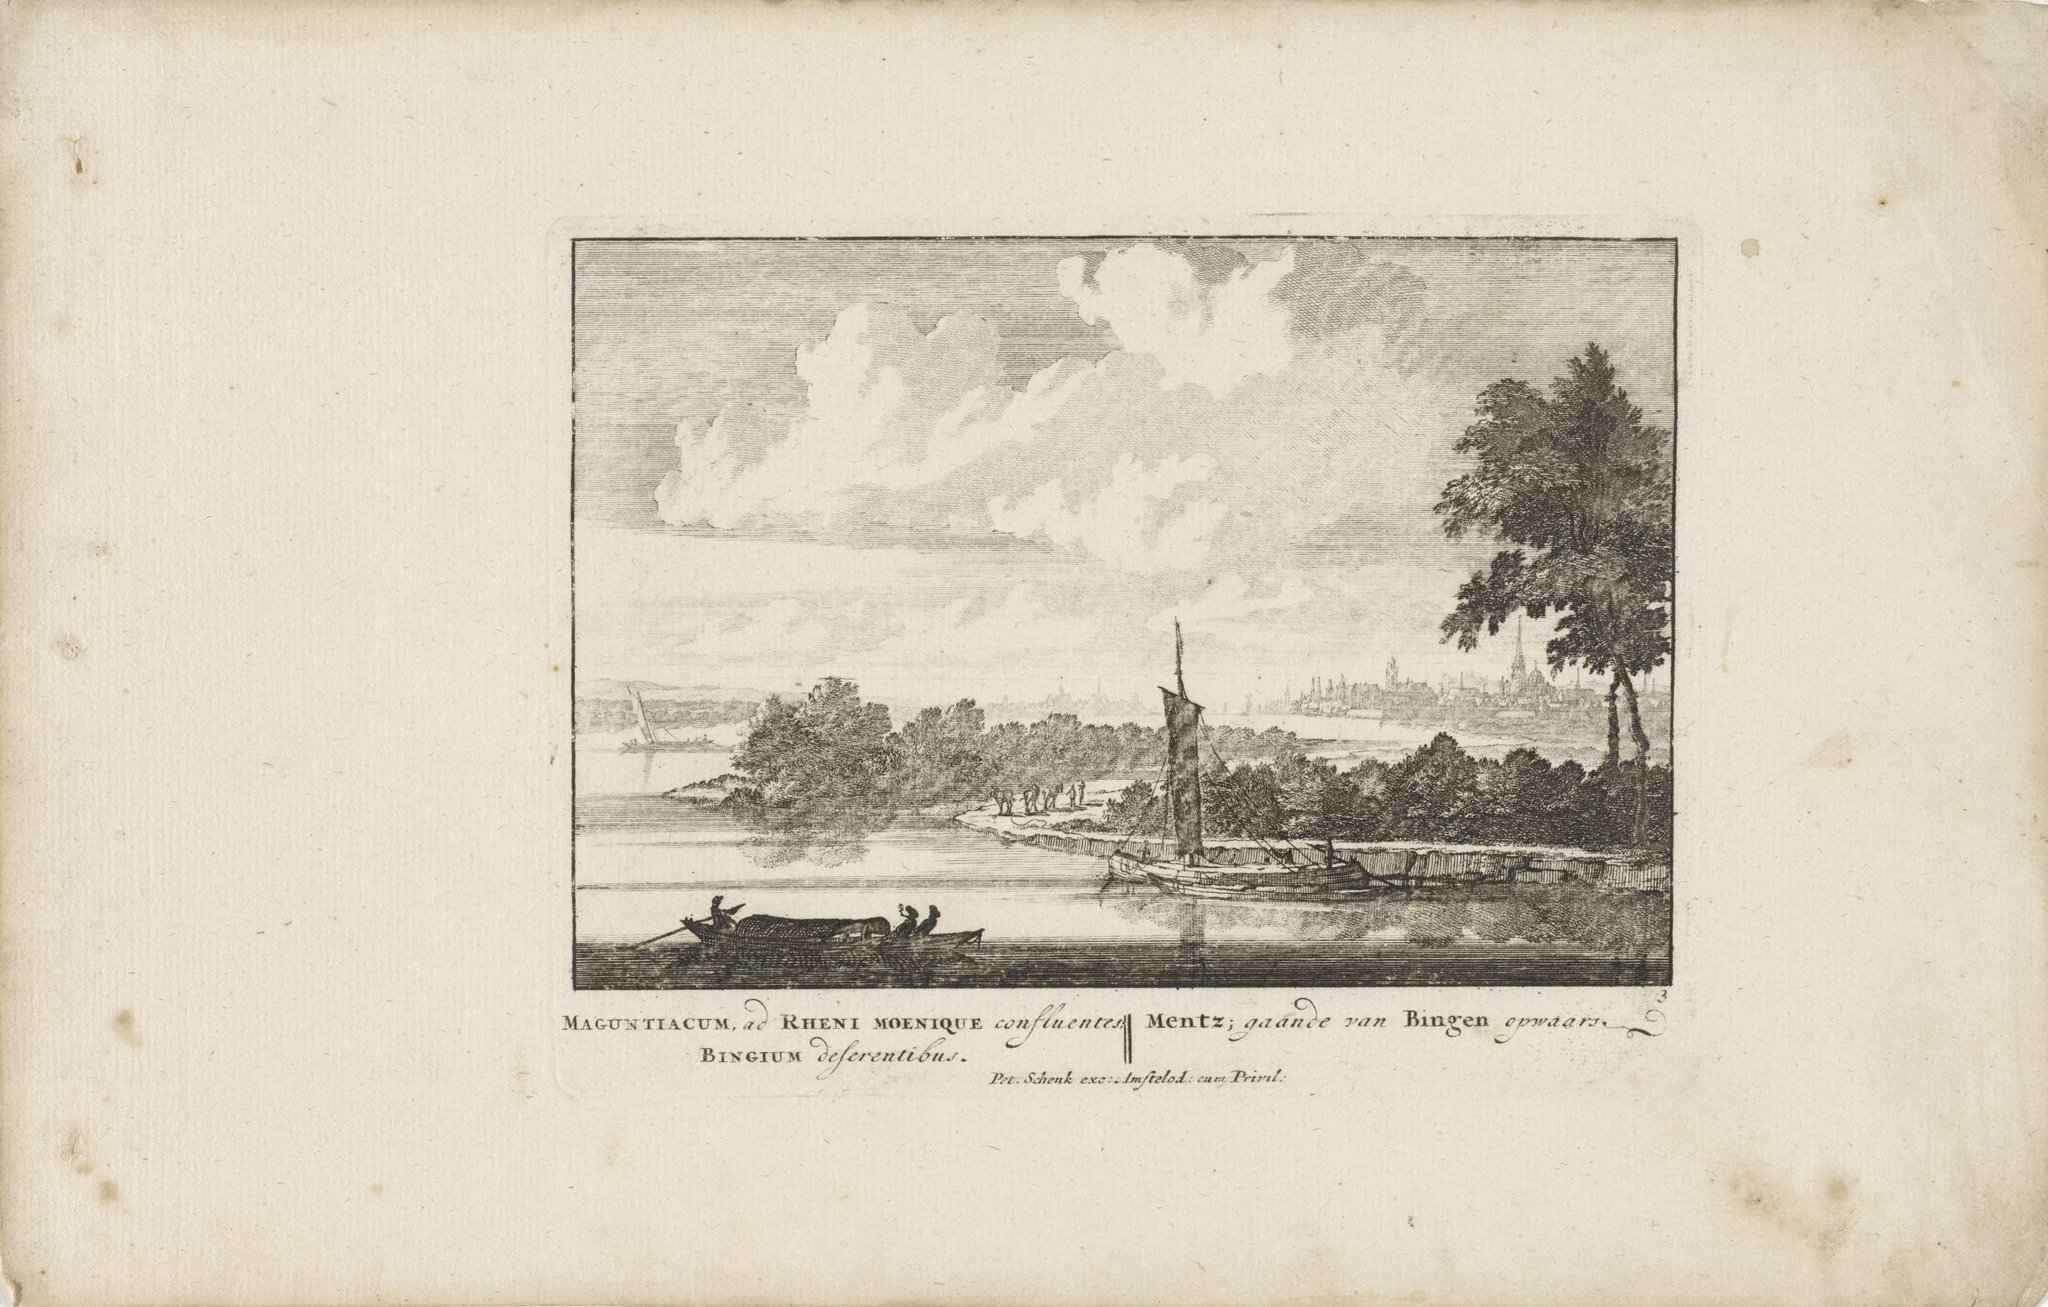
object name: print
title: Vermakelijke gezigten aan den Rhijnstroom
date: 1694-1697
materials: paper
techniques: etching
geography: amsterdam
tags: city-view in general; 'veduta', river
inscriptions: collector's mark: Lugt 2228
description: Gezicht op Mainz vanuit het Noorden met op de voorgrond schepen op de Rijn. Prent uit een serie van 71 prenten met Rijnlandschappen, gezichten op vorstelijke paleizen en stadsgezichten uit Den Haag en Amsterdam.